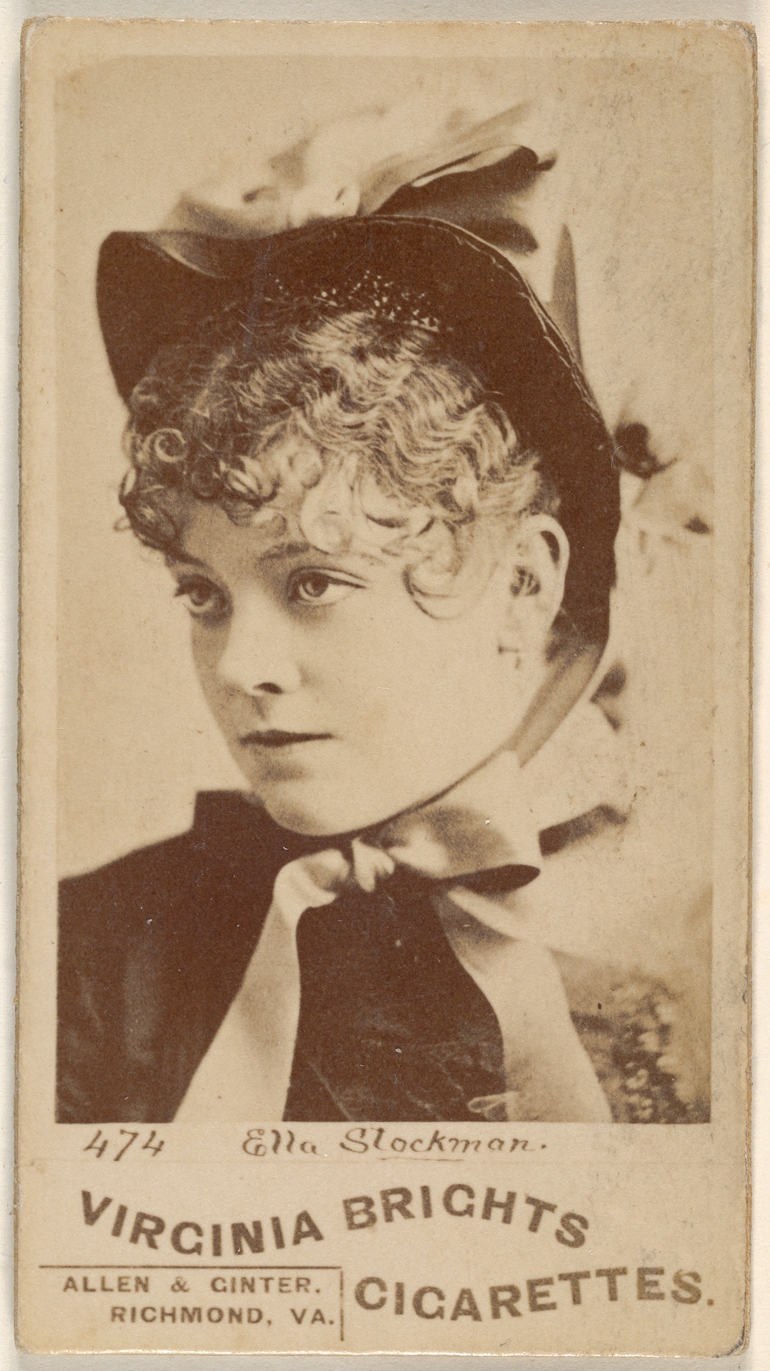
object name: photograph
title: Card 474, Ella Stockman, from the Actors and Actresses series (N45, Type 1) for Virginia Brights Cigarettes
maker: allen & ginter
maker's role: publisher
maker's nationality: american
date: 1888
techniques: albumen silver print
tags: portraits,women,actresses